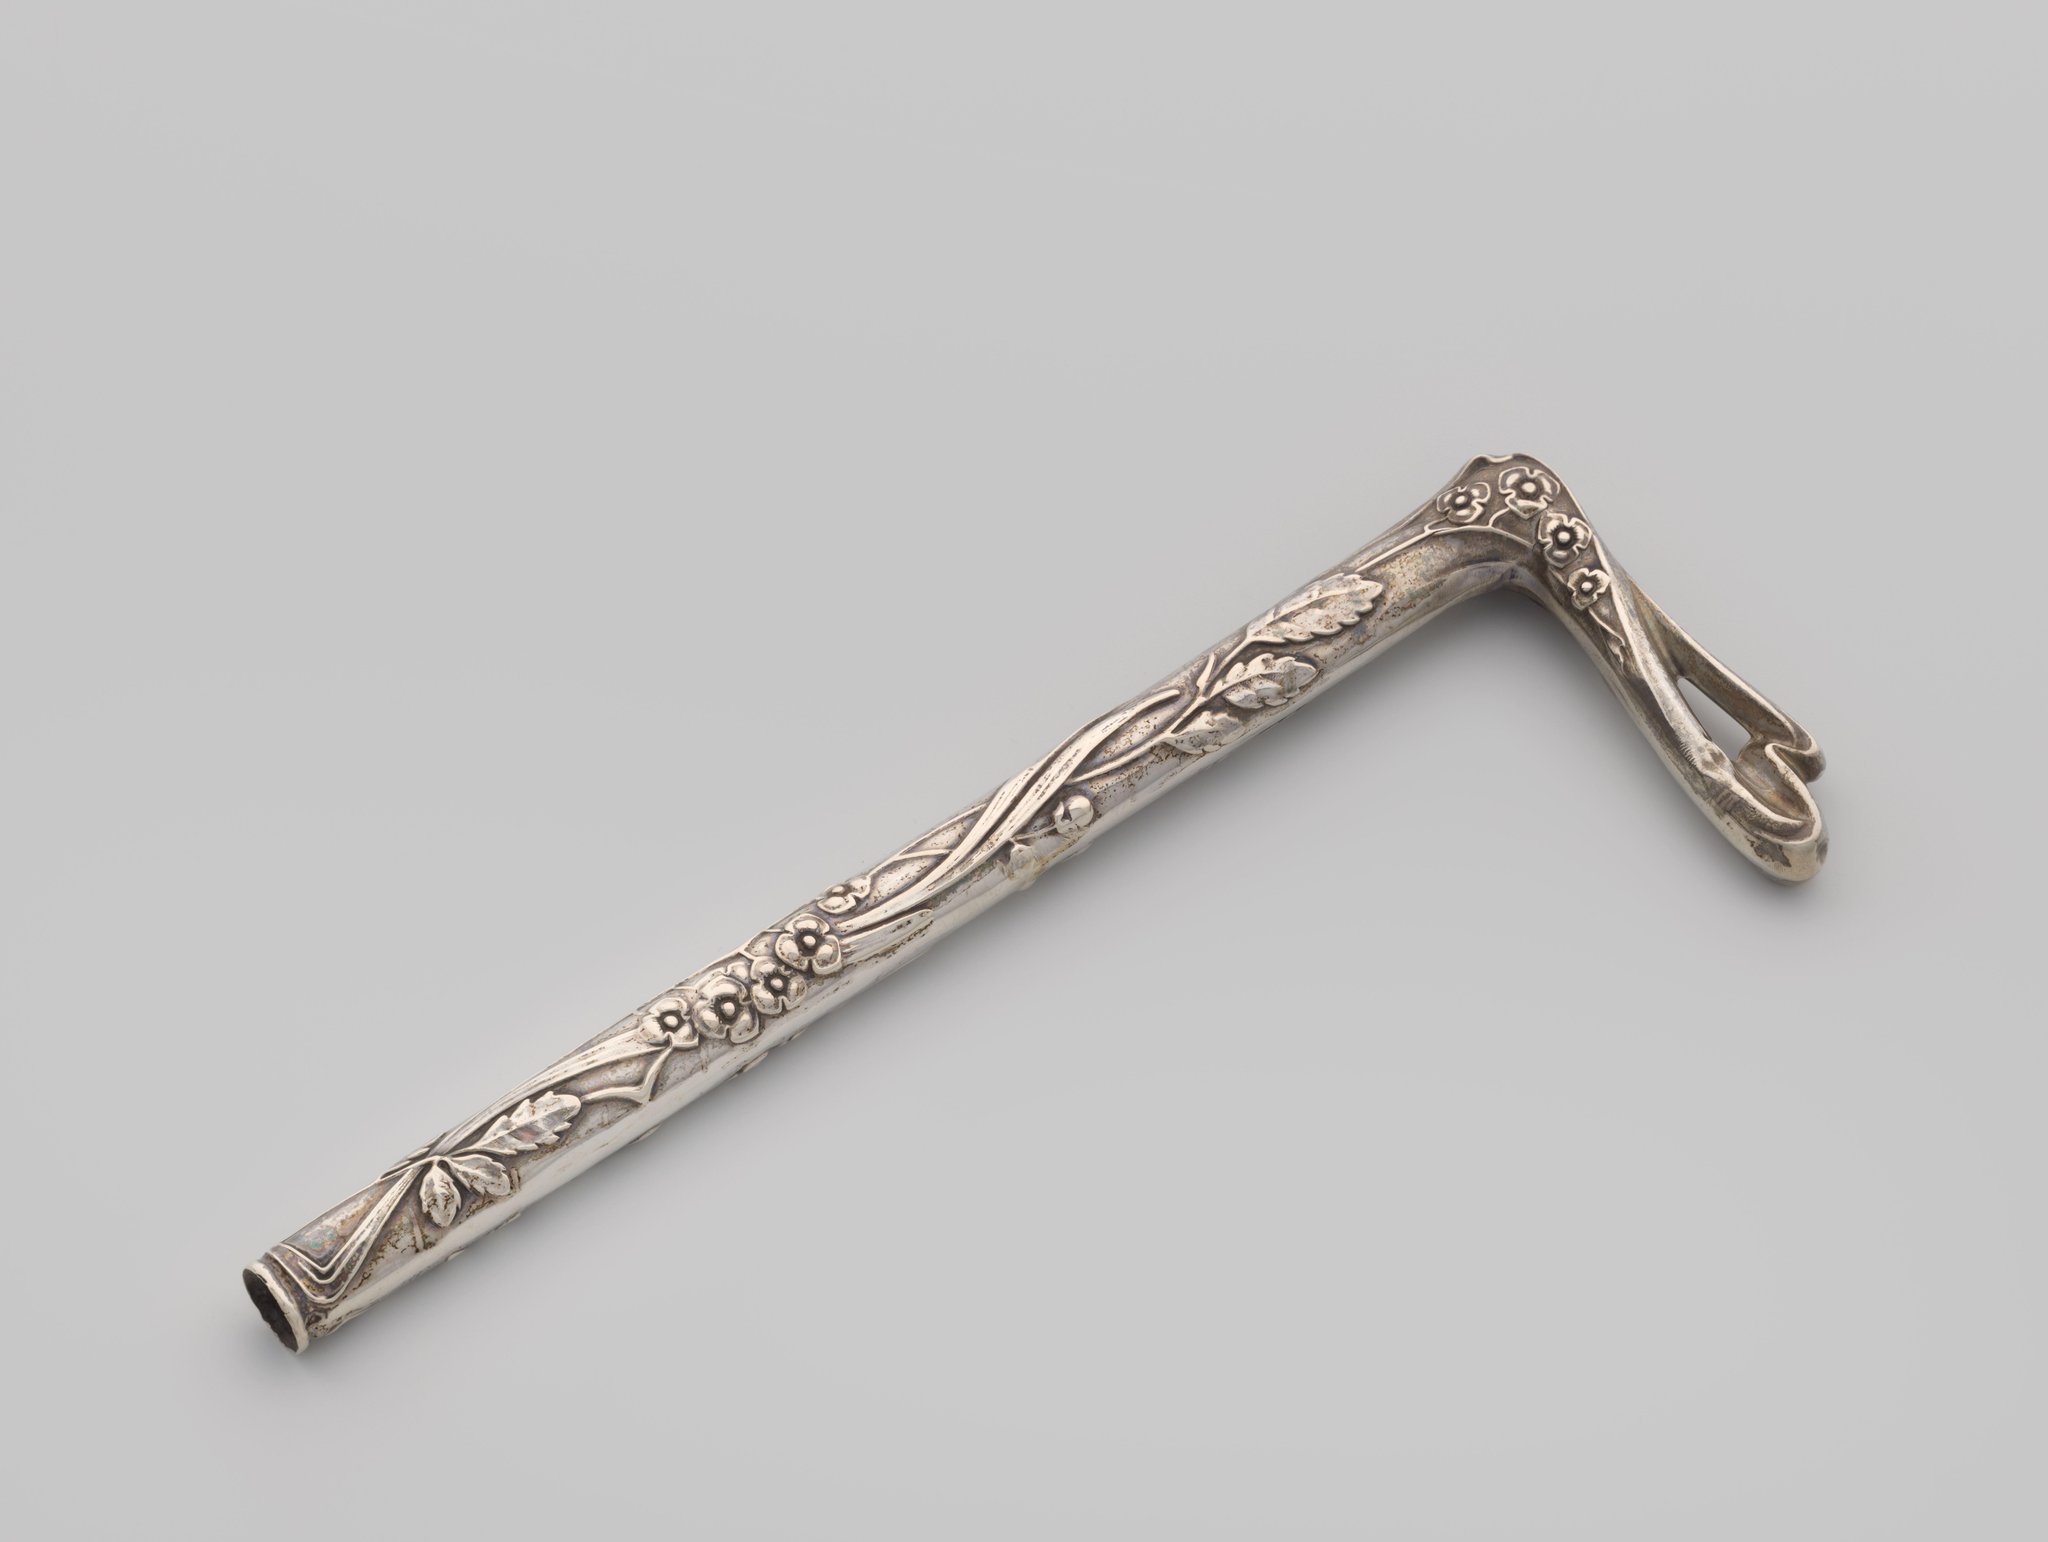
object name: parasolknop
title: Parasolknop met Jugendstil-ornament.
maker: Anonymous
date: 1900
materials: silver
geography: germany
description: Parasolknop van zilver, versierd met Jugendstil-ornament in reliëf. Meestertekens: een klimmend dier (eenhoorn ?) in staand ovaal, en een zwijntje.